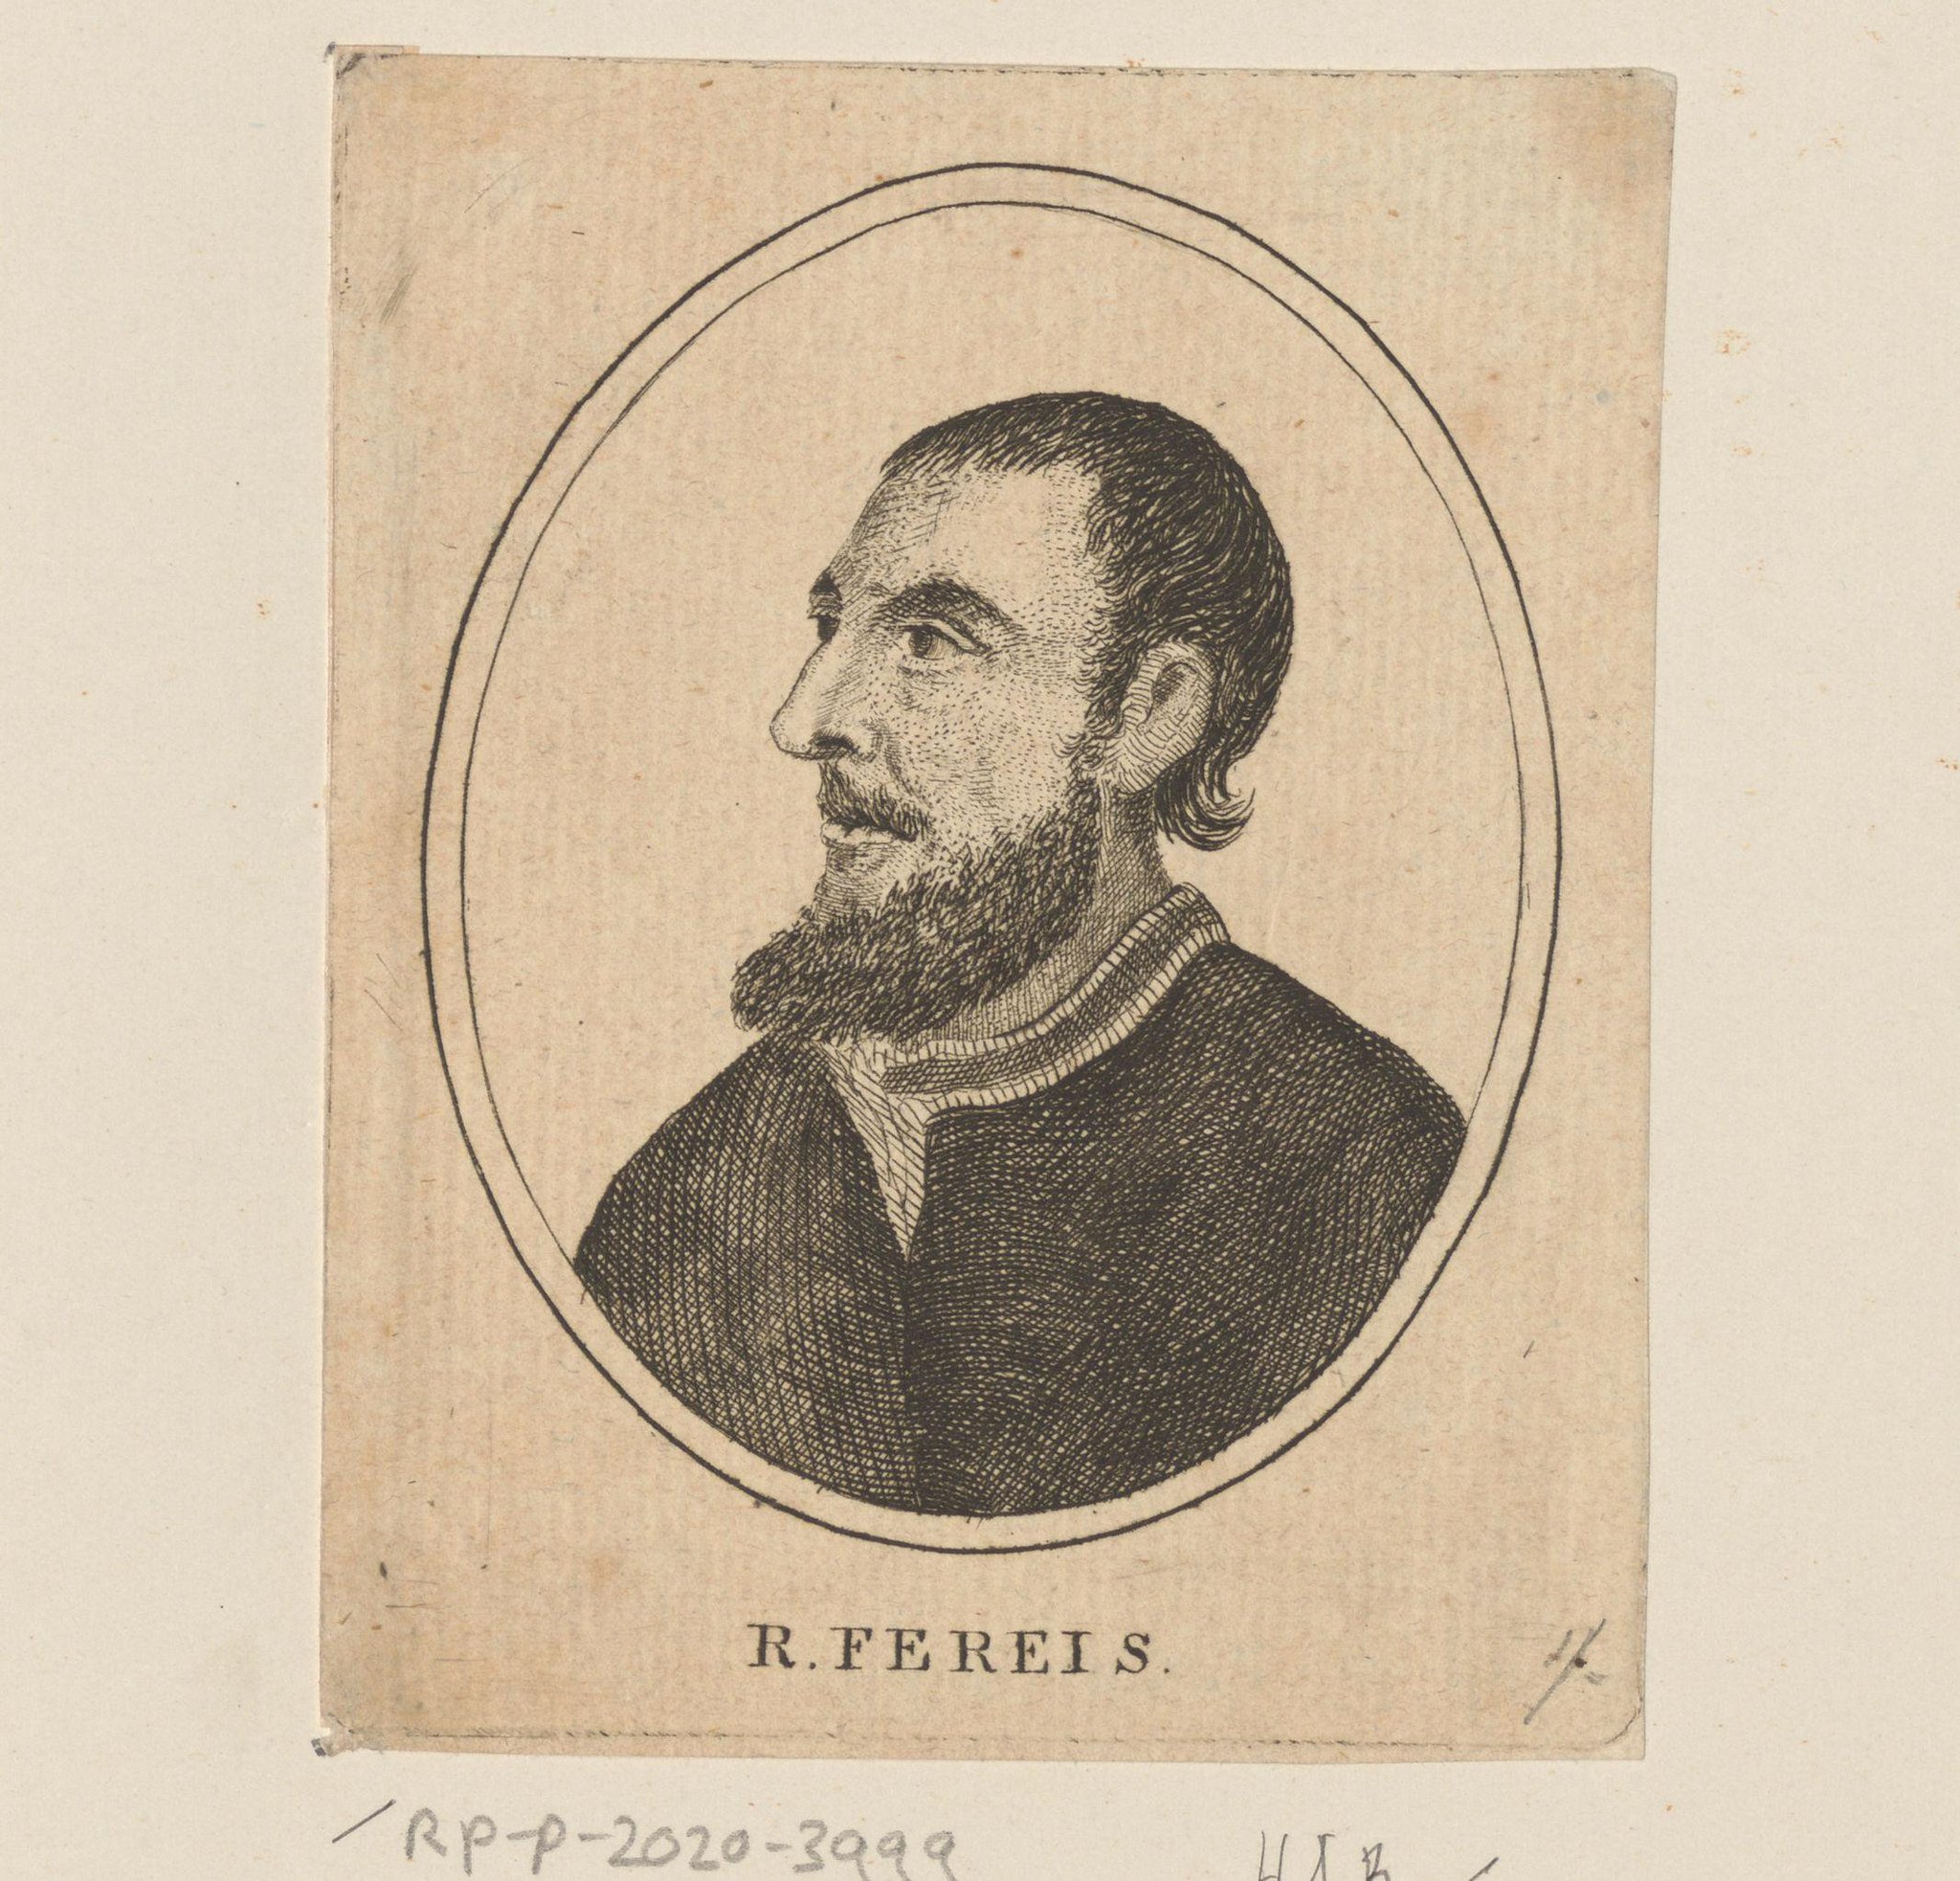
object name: print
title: Portret van R. Fereis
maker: Anonymous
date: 1700-1800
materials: paper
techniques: etching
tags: historical persons